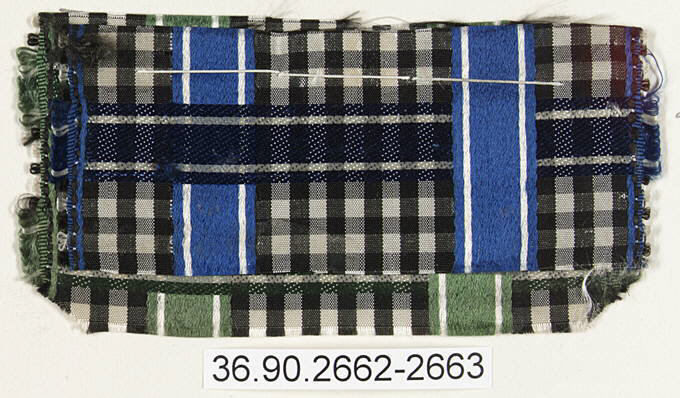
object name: ribbon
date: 1801-1900